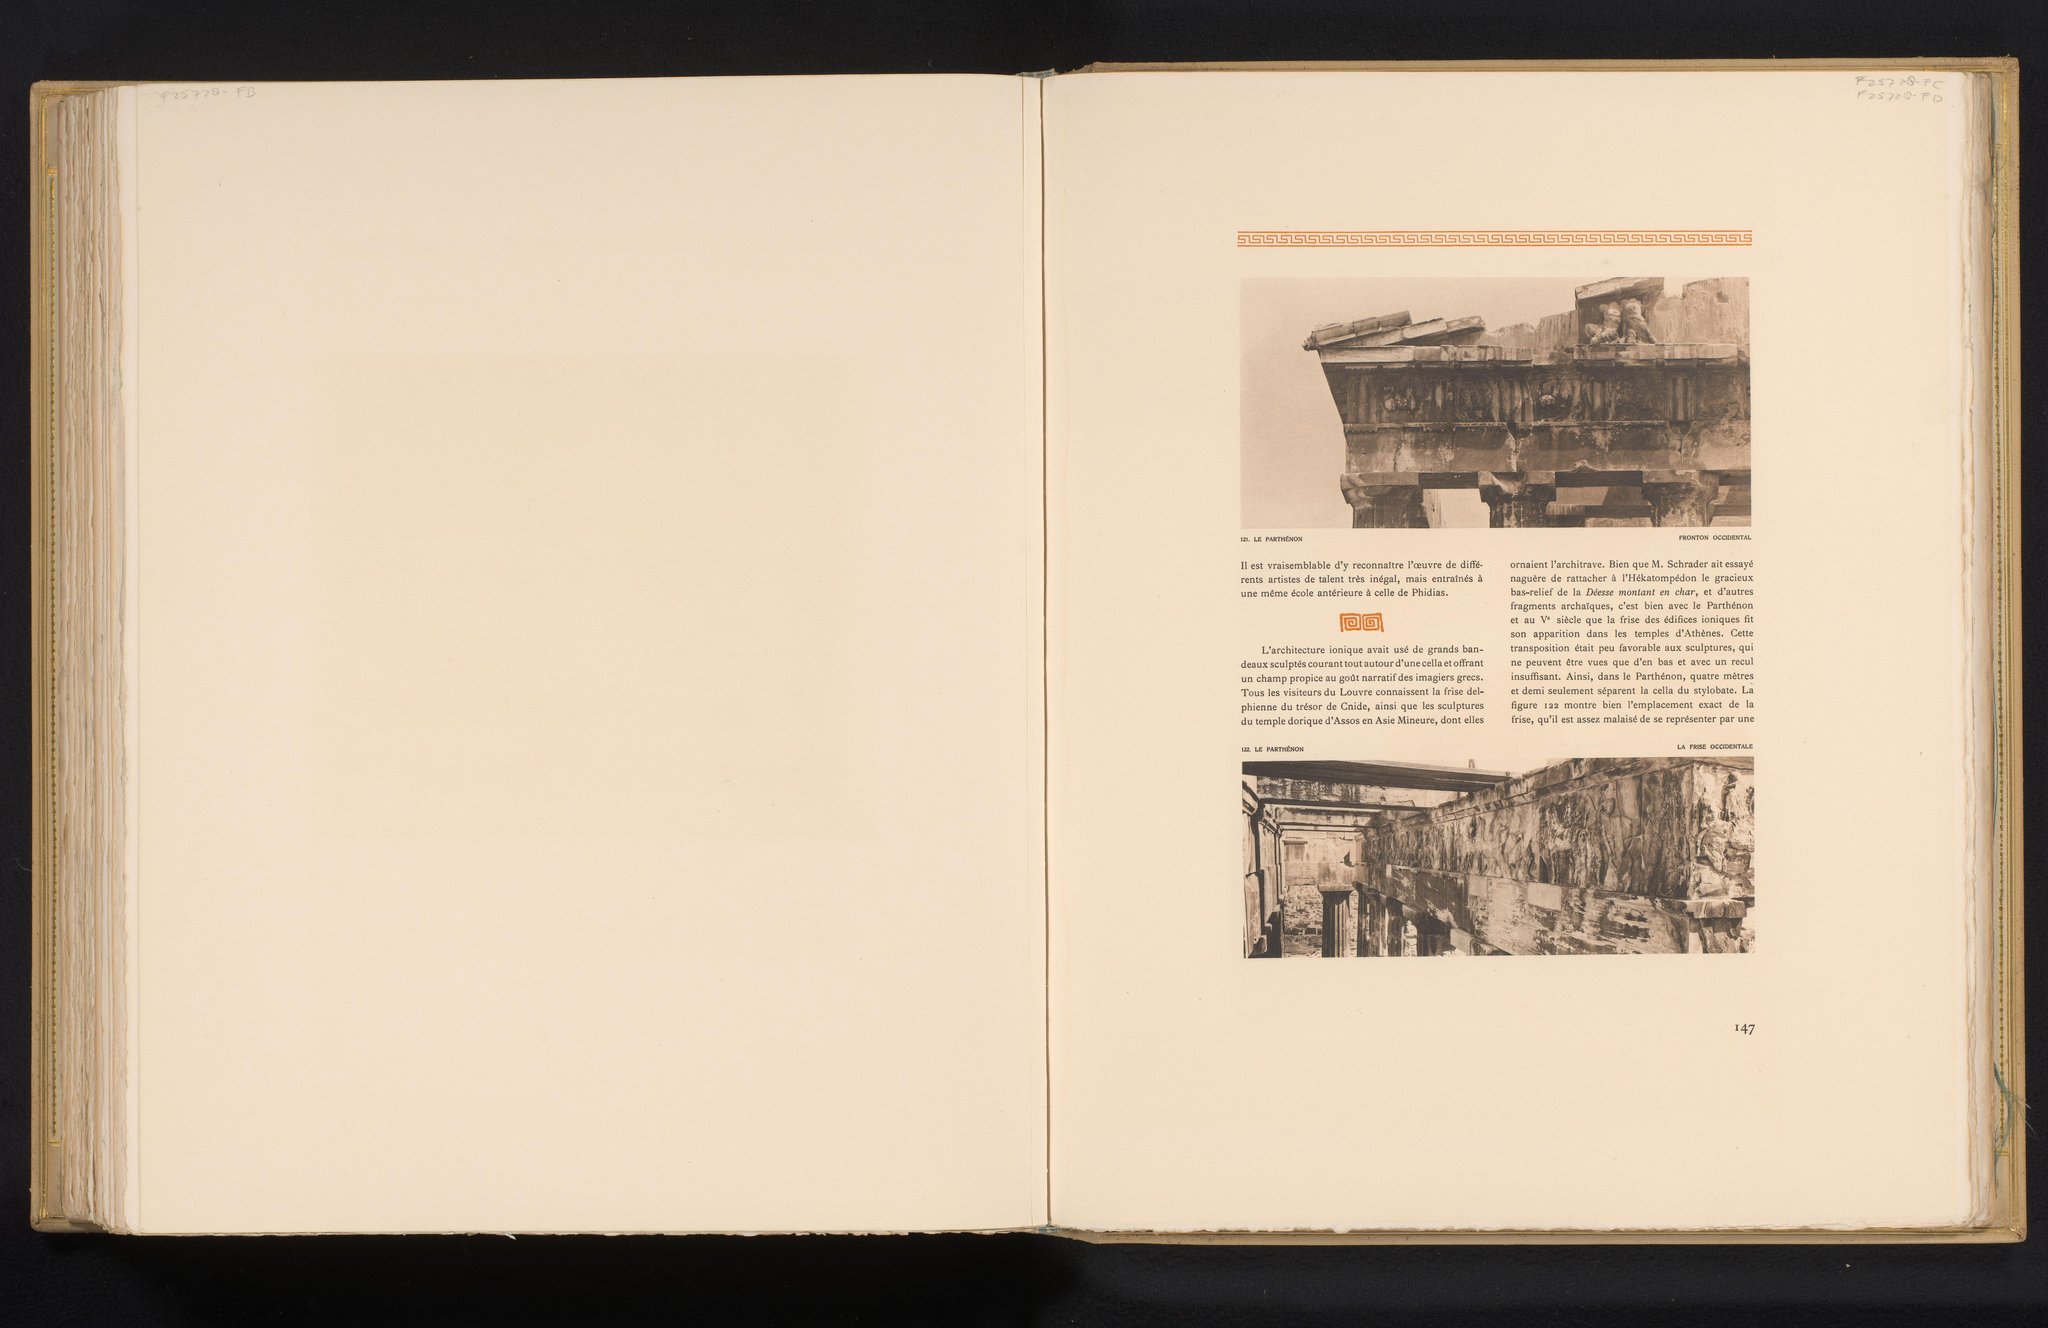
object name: page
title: Le Parthénon, la frise occidentale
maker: frédéric boissonnas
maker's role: fotograaf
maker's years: 1858-1946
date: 1905-1910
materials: paper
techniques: photograph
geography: berlin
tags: sculpture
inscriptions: number: ‘122.’